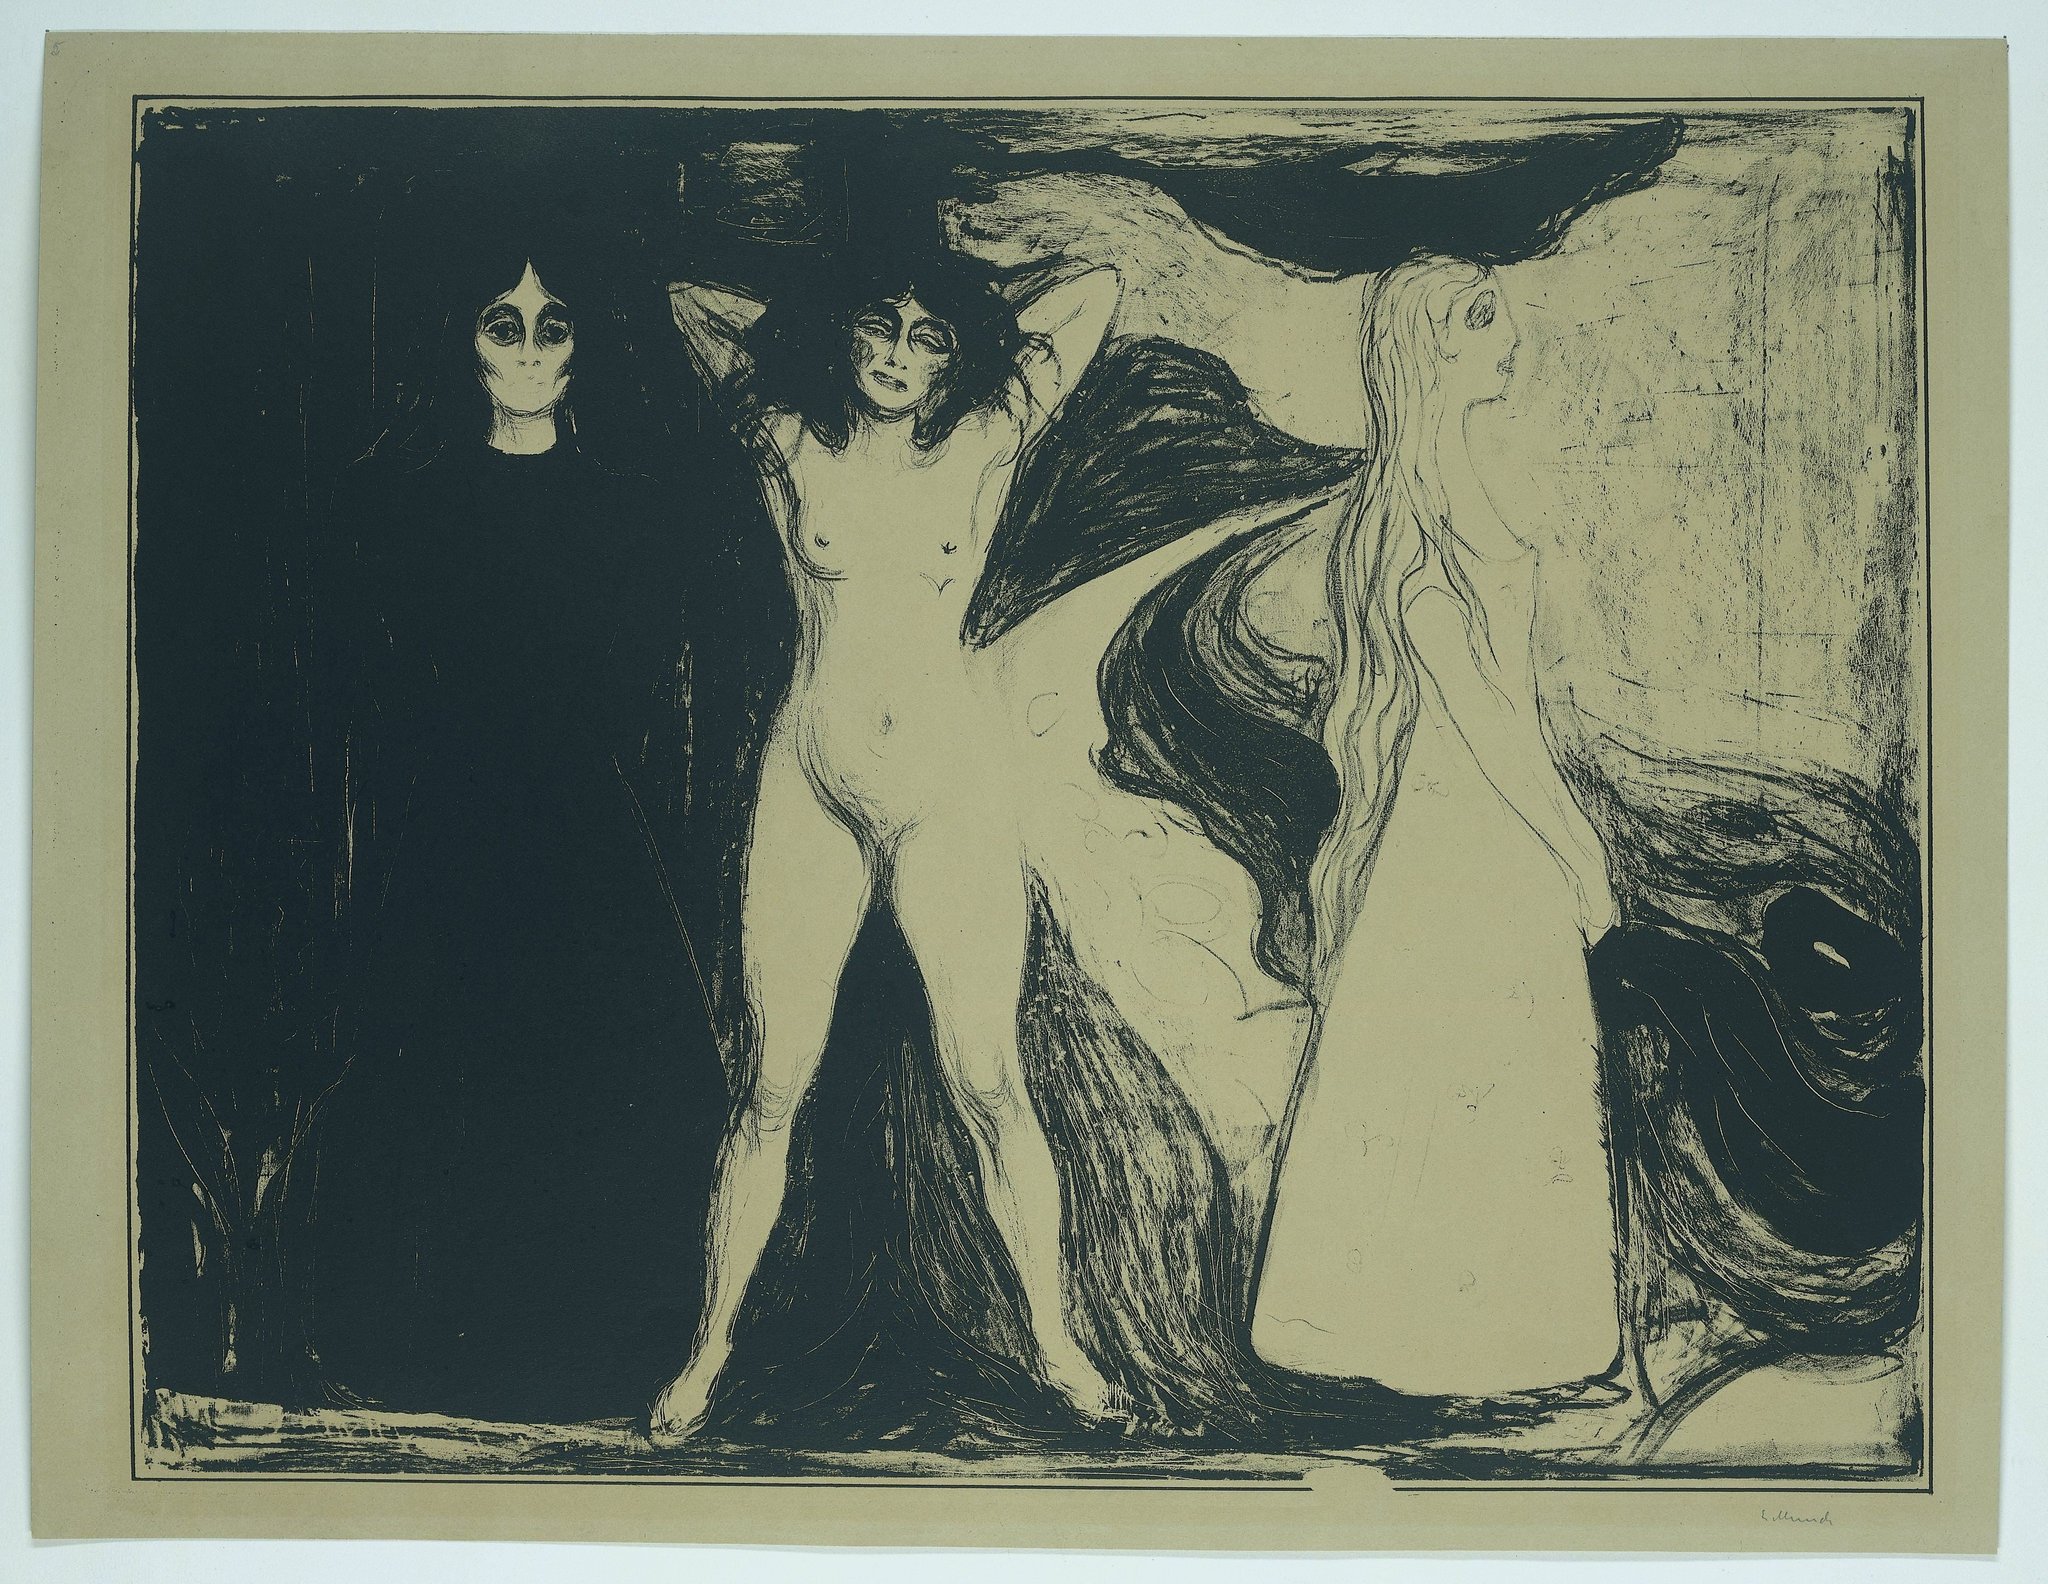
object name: print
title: Woman (sphinx)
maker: edvard munch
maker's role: print maker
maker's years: 1863-1944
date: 1894-1944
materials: paper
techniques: lithograph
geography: norway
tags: young versus old age; young and old, human life divided into stages, e.g. three, four, seven, twelve stages (with number)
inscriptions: stamp: ‘leeuw op wapenschild’, collector's mark: Lugt 2228, collector's mark: Lugt 2760